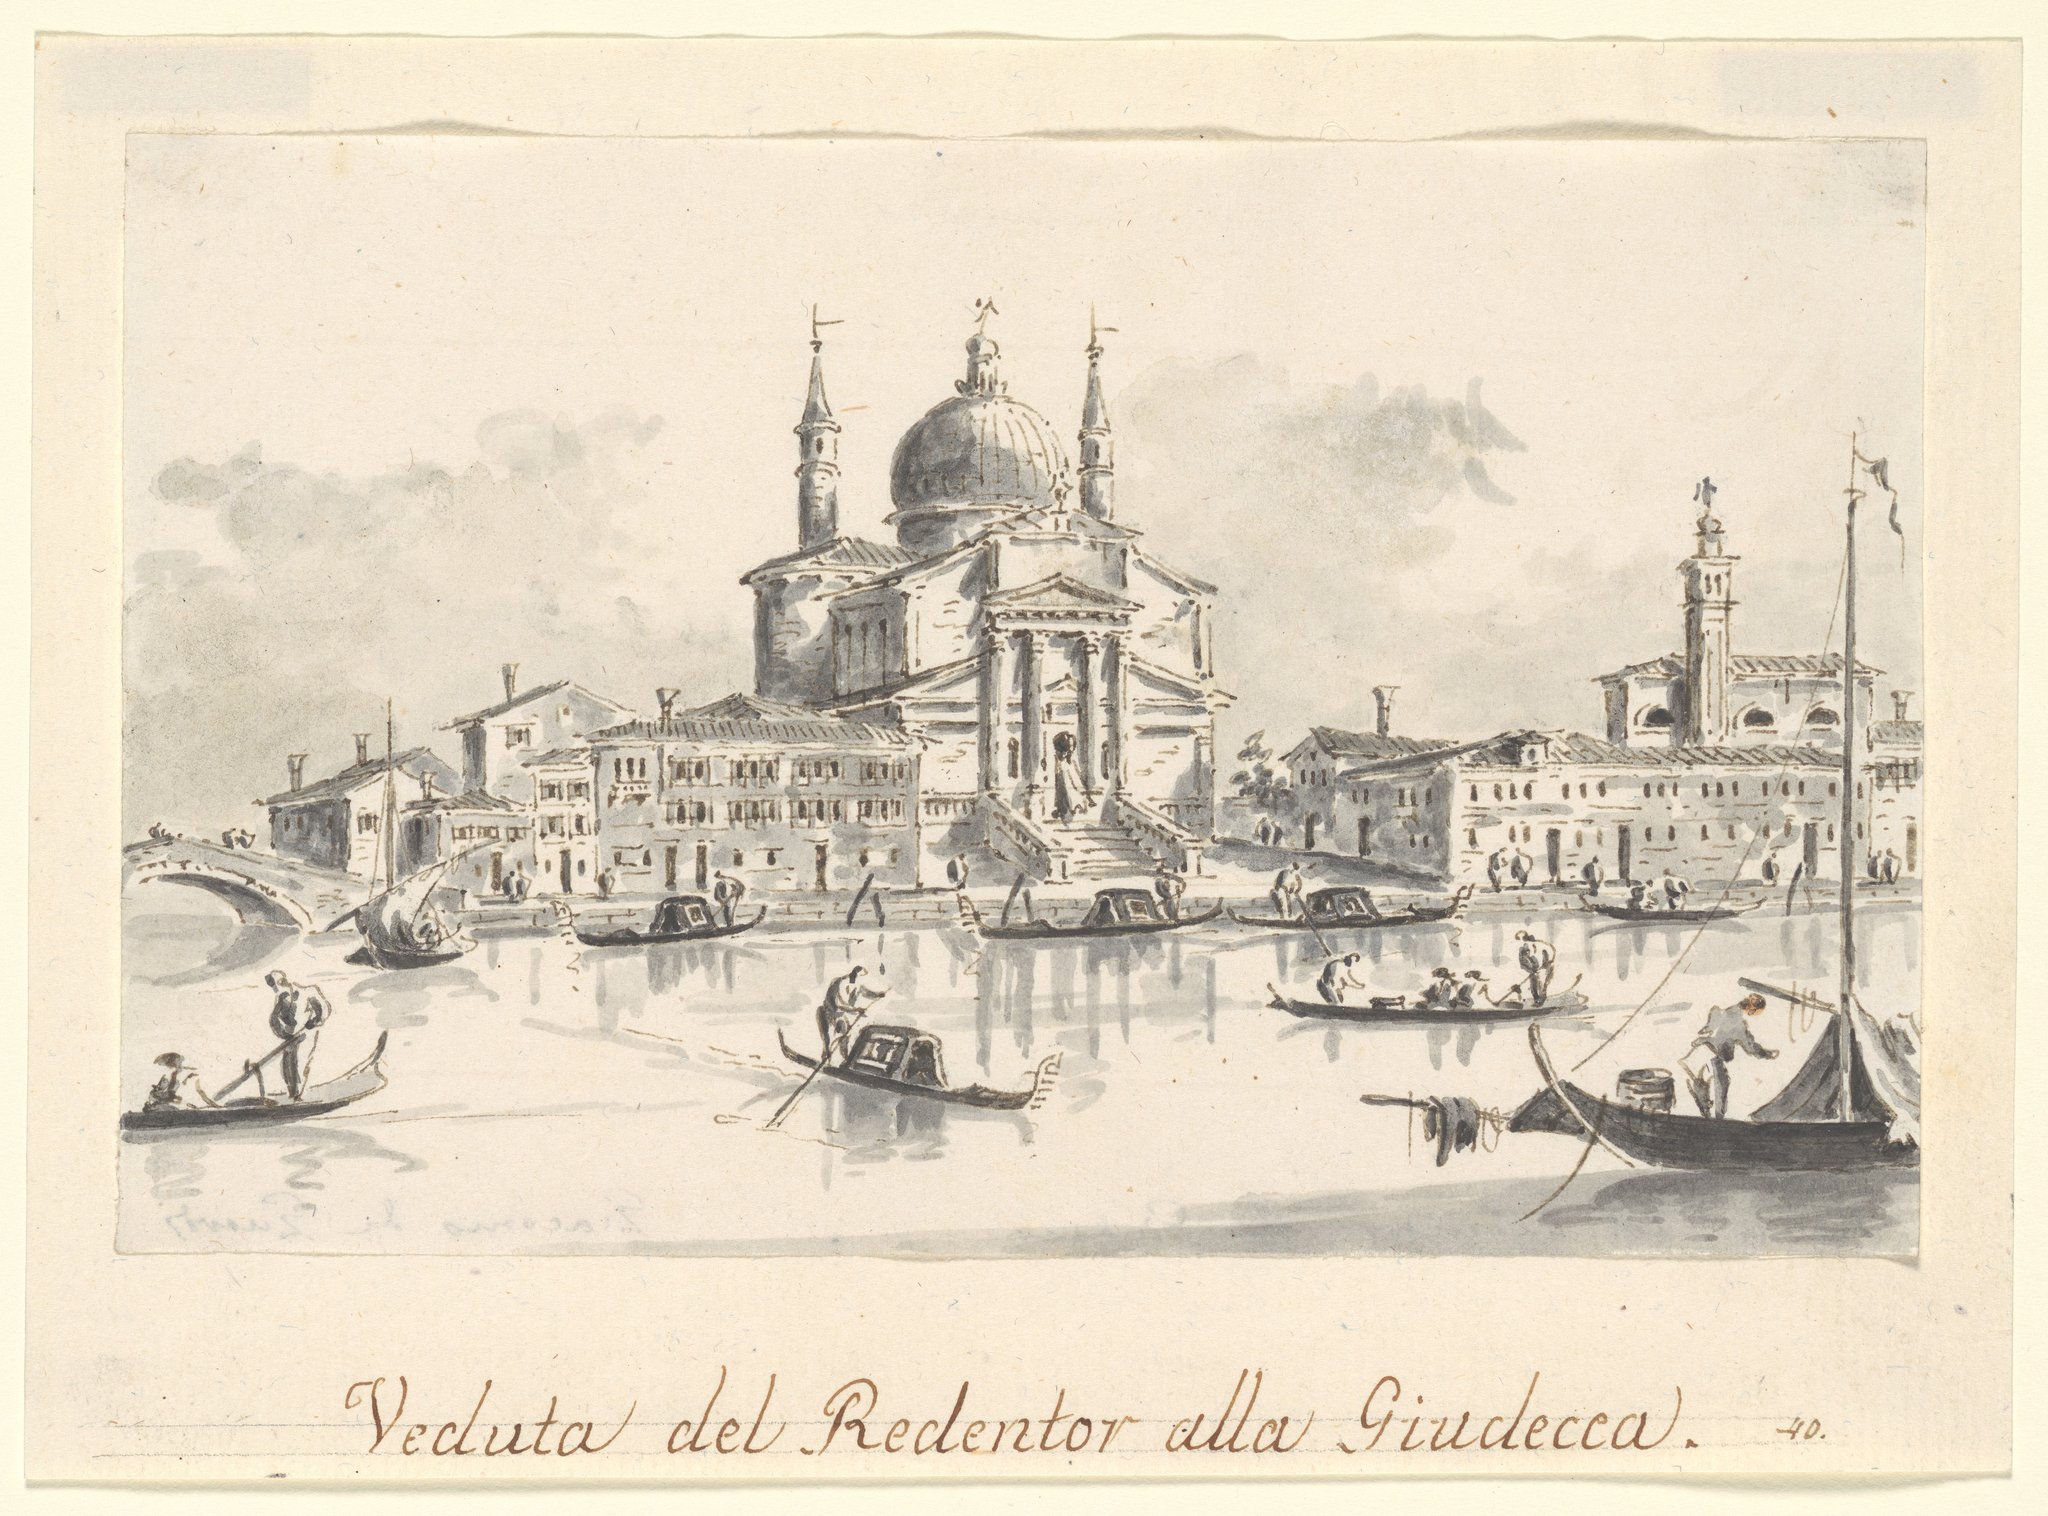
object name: drawing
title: The Church of the Redentore from the Giudecca Canal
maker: giacomo guardi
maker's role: artist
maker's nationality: italian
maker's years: 1764-1835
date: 1804-1828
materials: ink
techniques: pen, wash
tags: churches,canals,boats